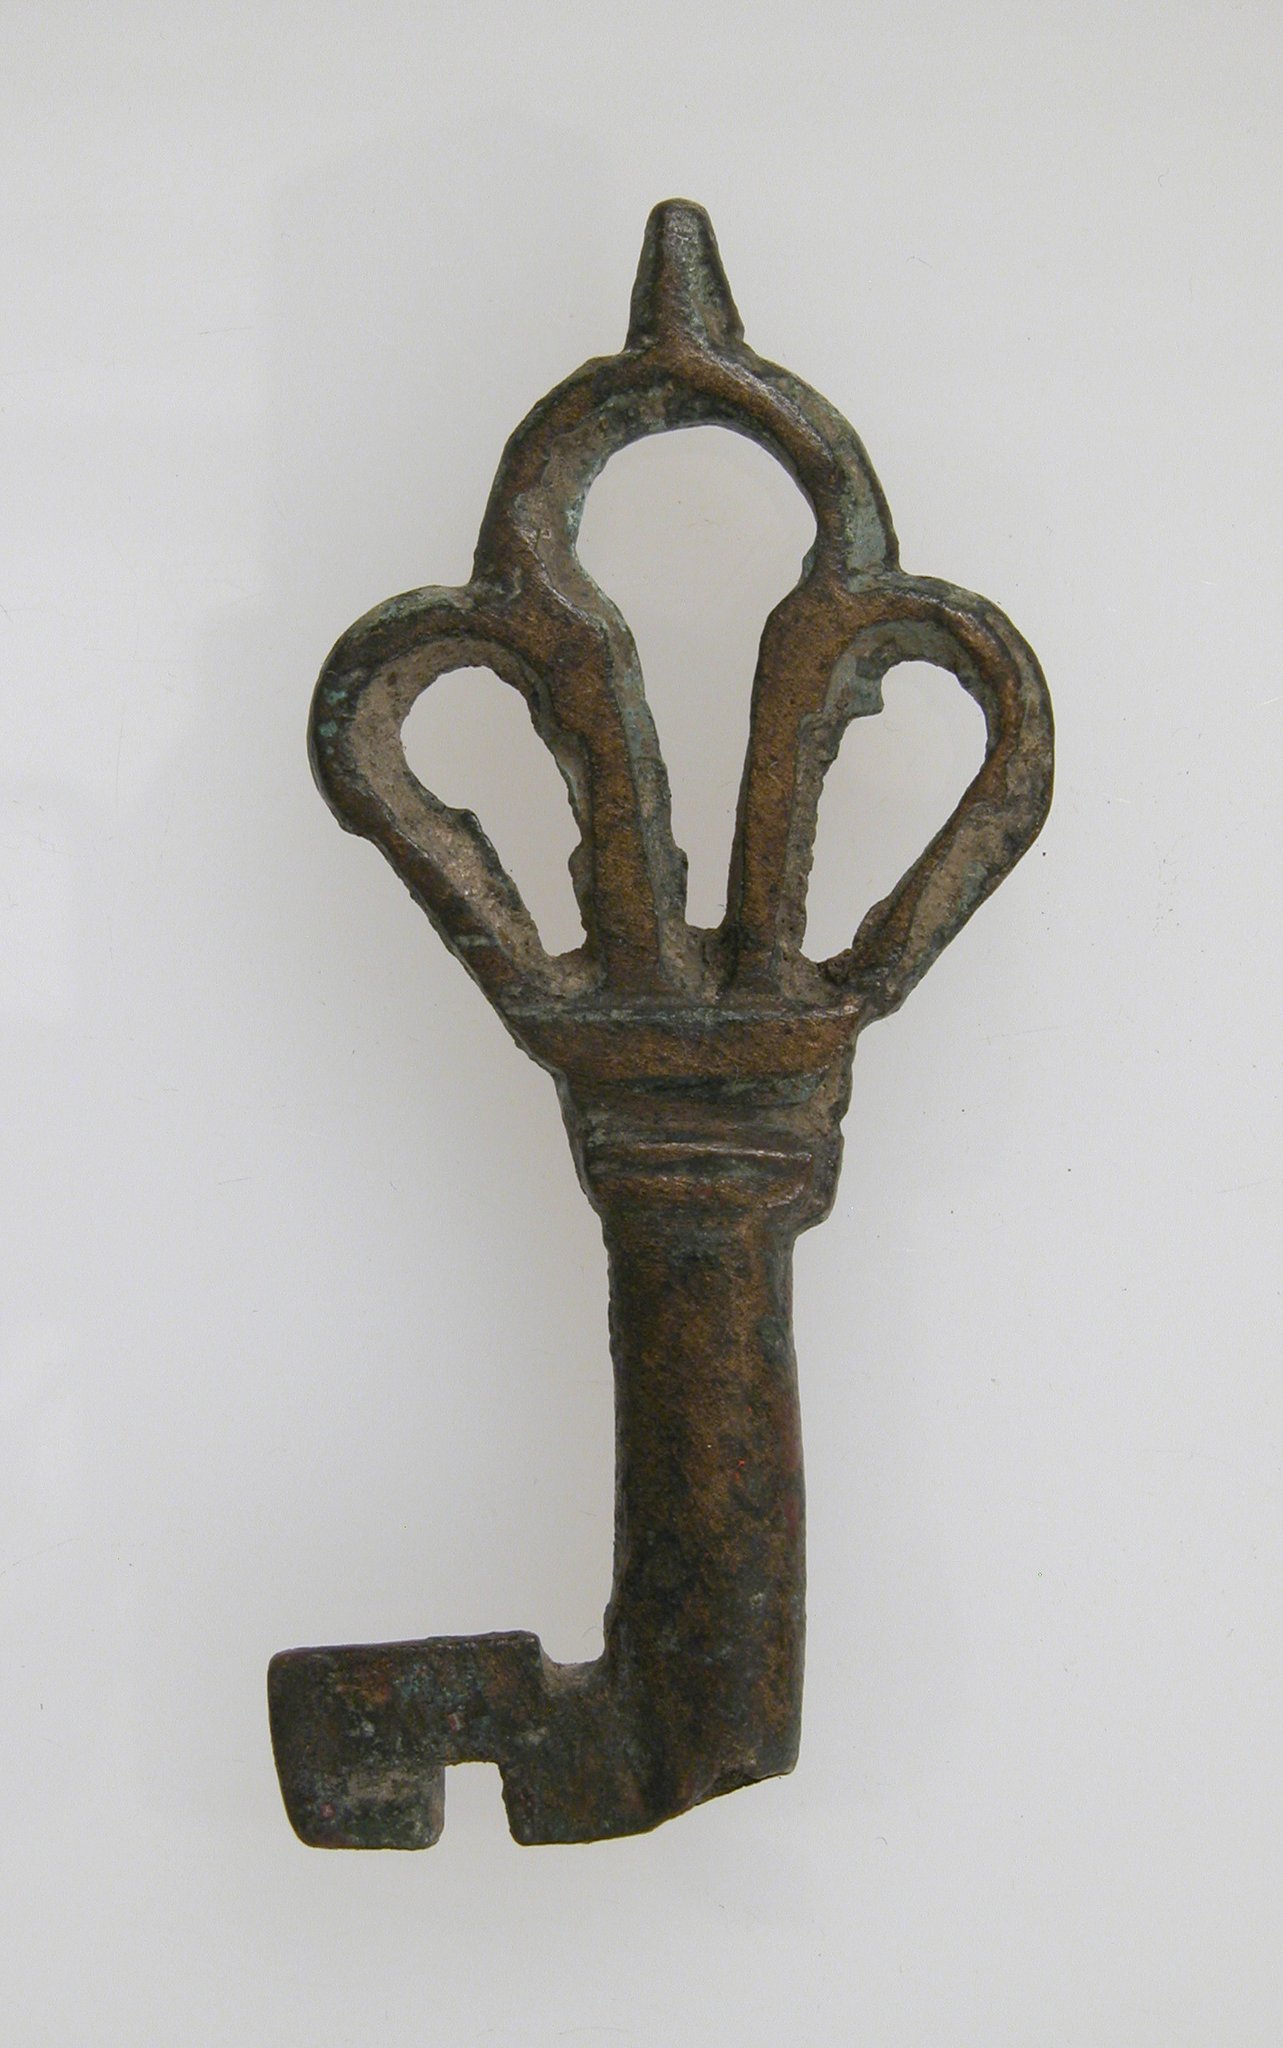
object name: key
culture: roman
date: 1-700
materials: copper alloy